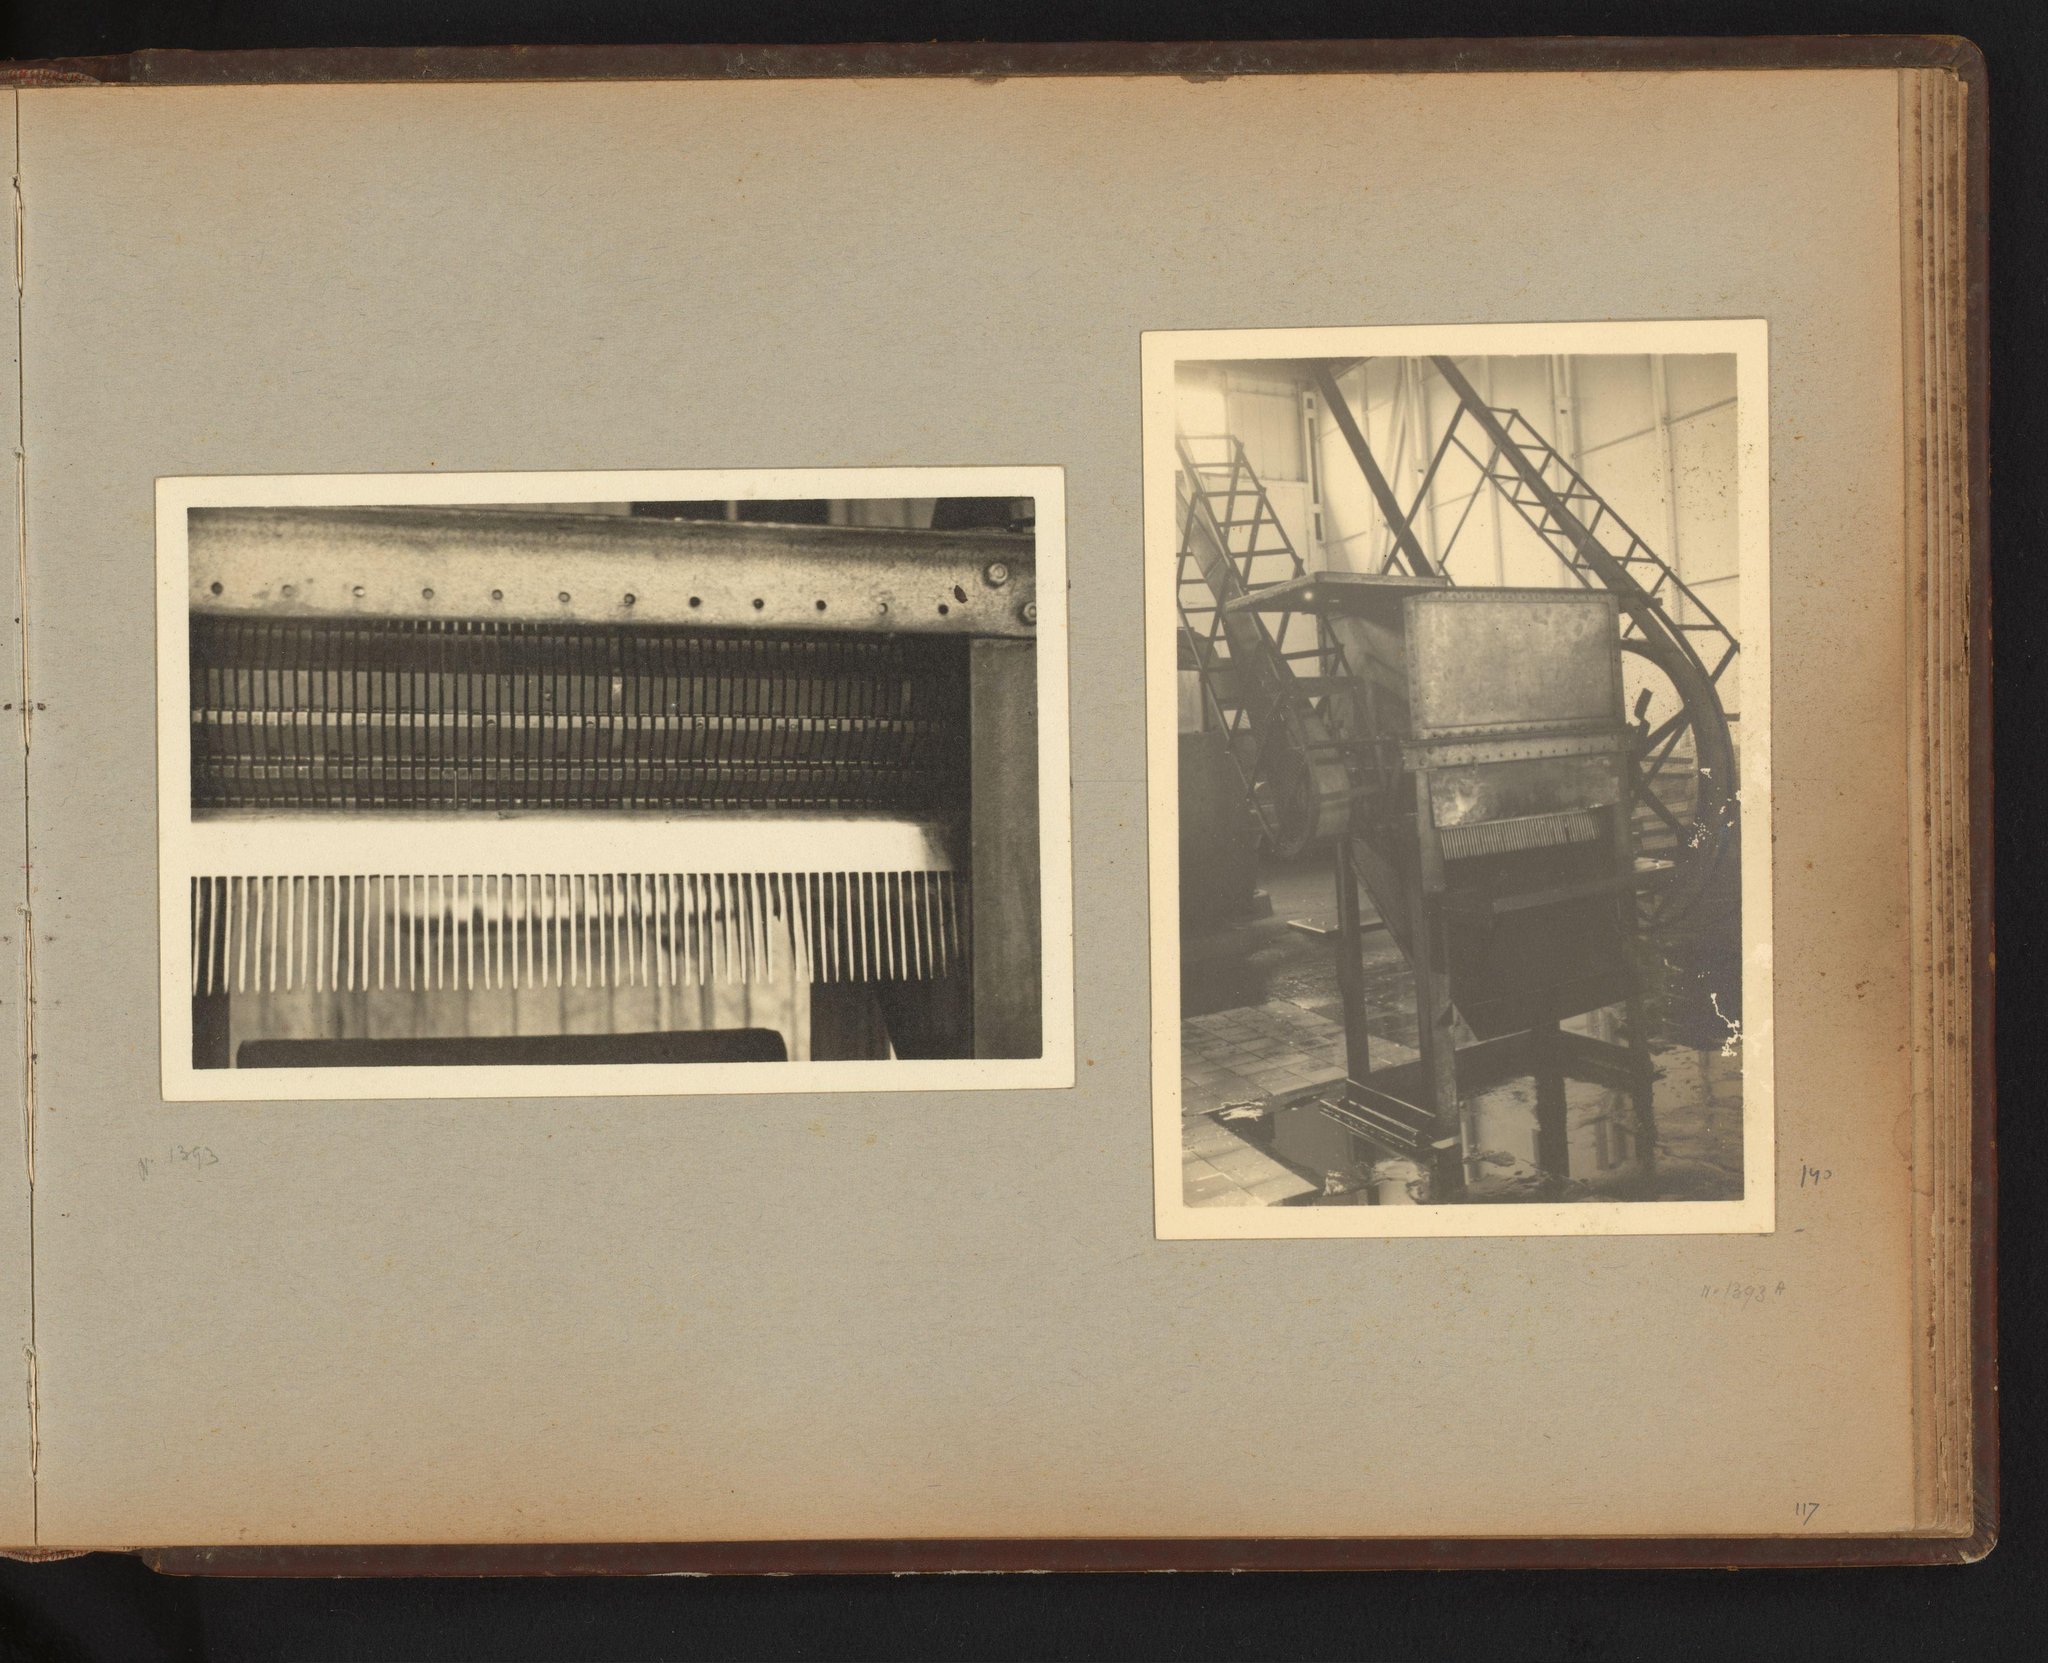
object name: photograph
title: Machine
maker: Anonymous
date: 1931-1937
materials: cardboard, photographic support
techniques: gelatin silver print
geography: java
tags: machines; parts of machines; tools and appliances, java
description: Albumblad met twee foto's van een machine. Onderdeel van een fotoalbum met foto's van machines en constructies van de N.V. Machinefabriek Braat te Soerabaja, Soekaboemi en Tegal uit de periode 1931-1937.